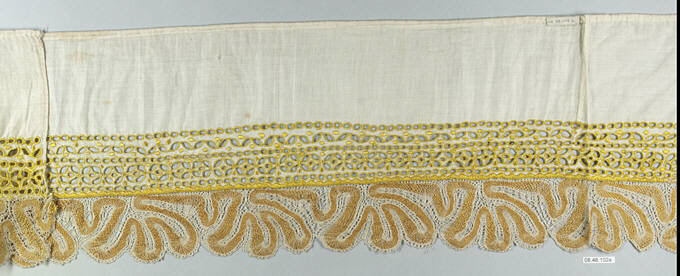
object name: cuff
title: Pair of cuffs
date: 1801-1900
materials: cotton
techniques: lace